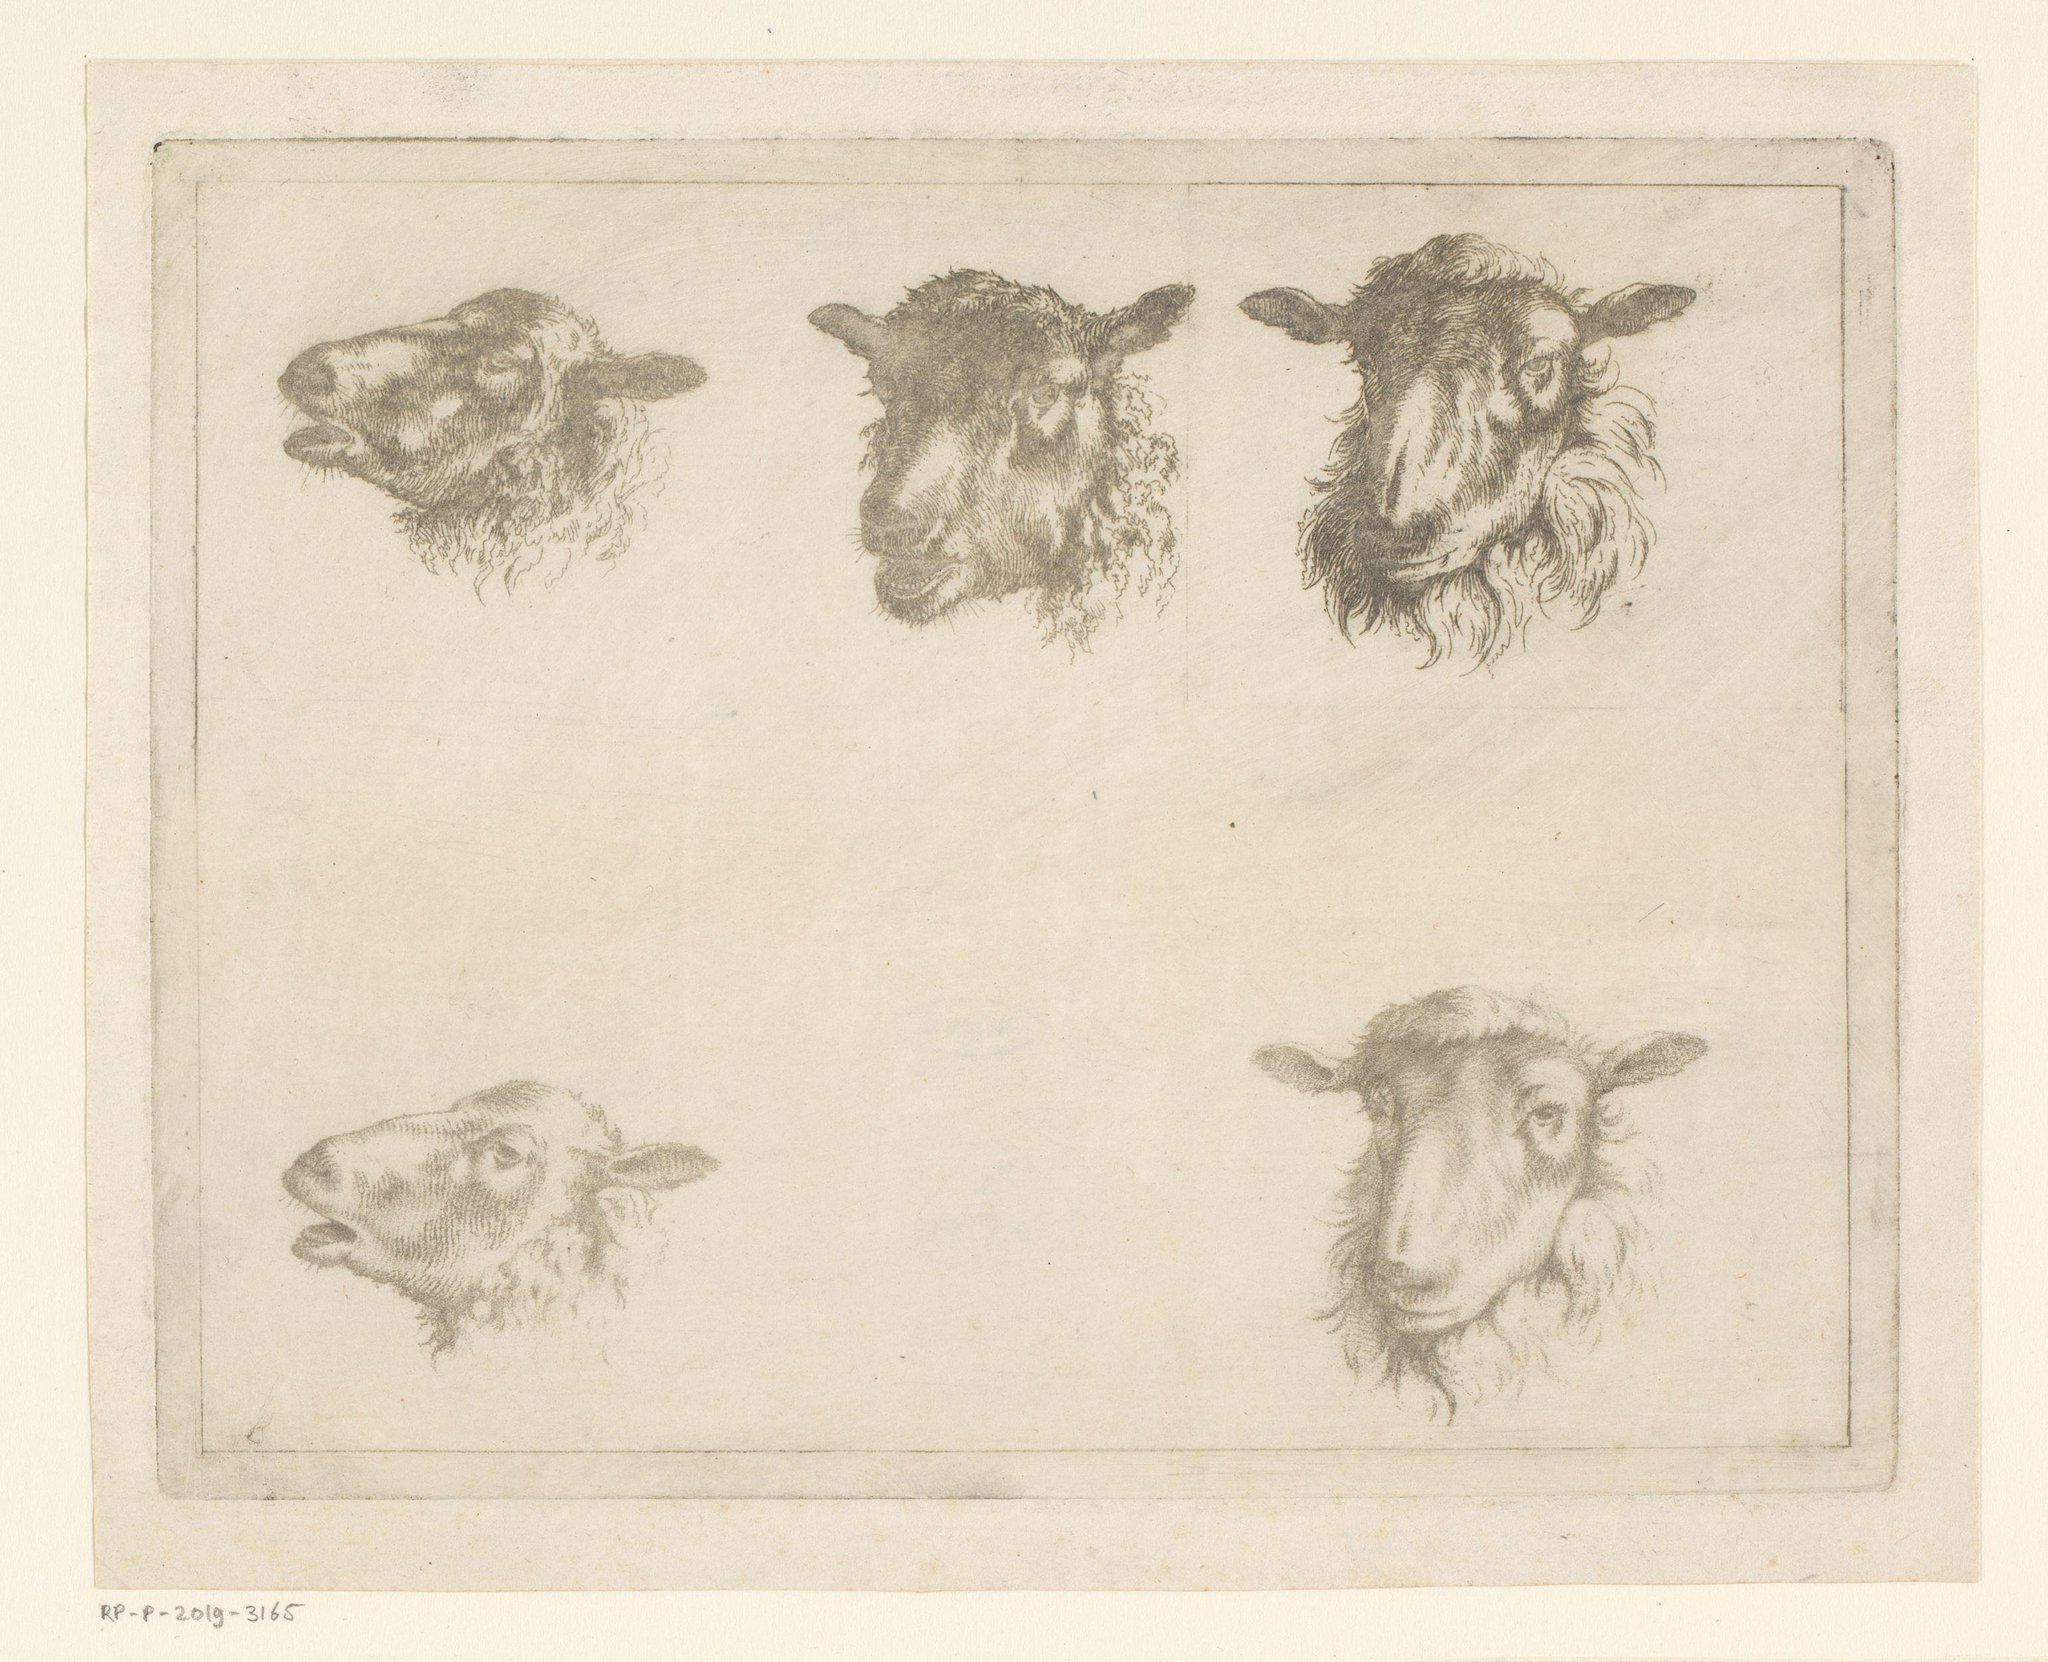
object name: print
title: Vijf schapenkoppen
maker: johannes janson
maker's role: draughtsman, painter, print maker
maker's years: 1729-1784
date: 1739-1784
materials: paper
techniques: etching, soft ground etching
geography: leiden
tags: sheep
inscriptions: collector's mark: Lugt 2228